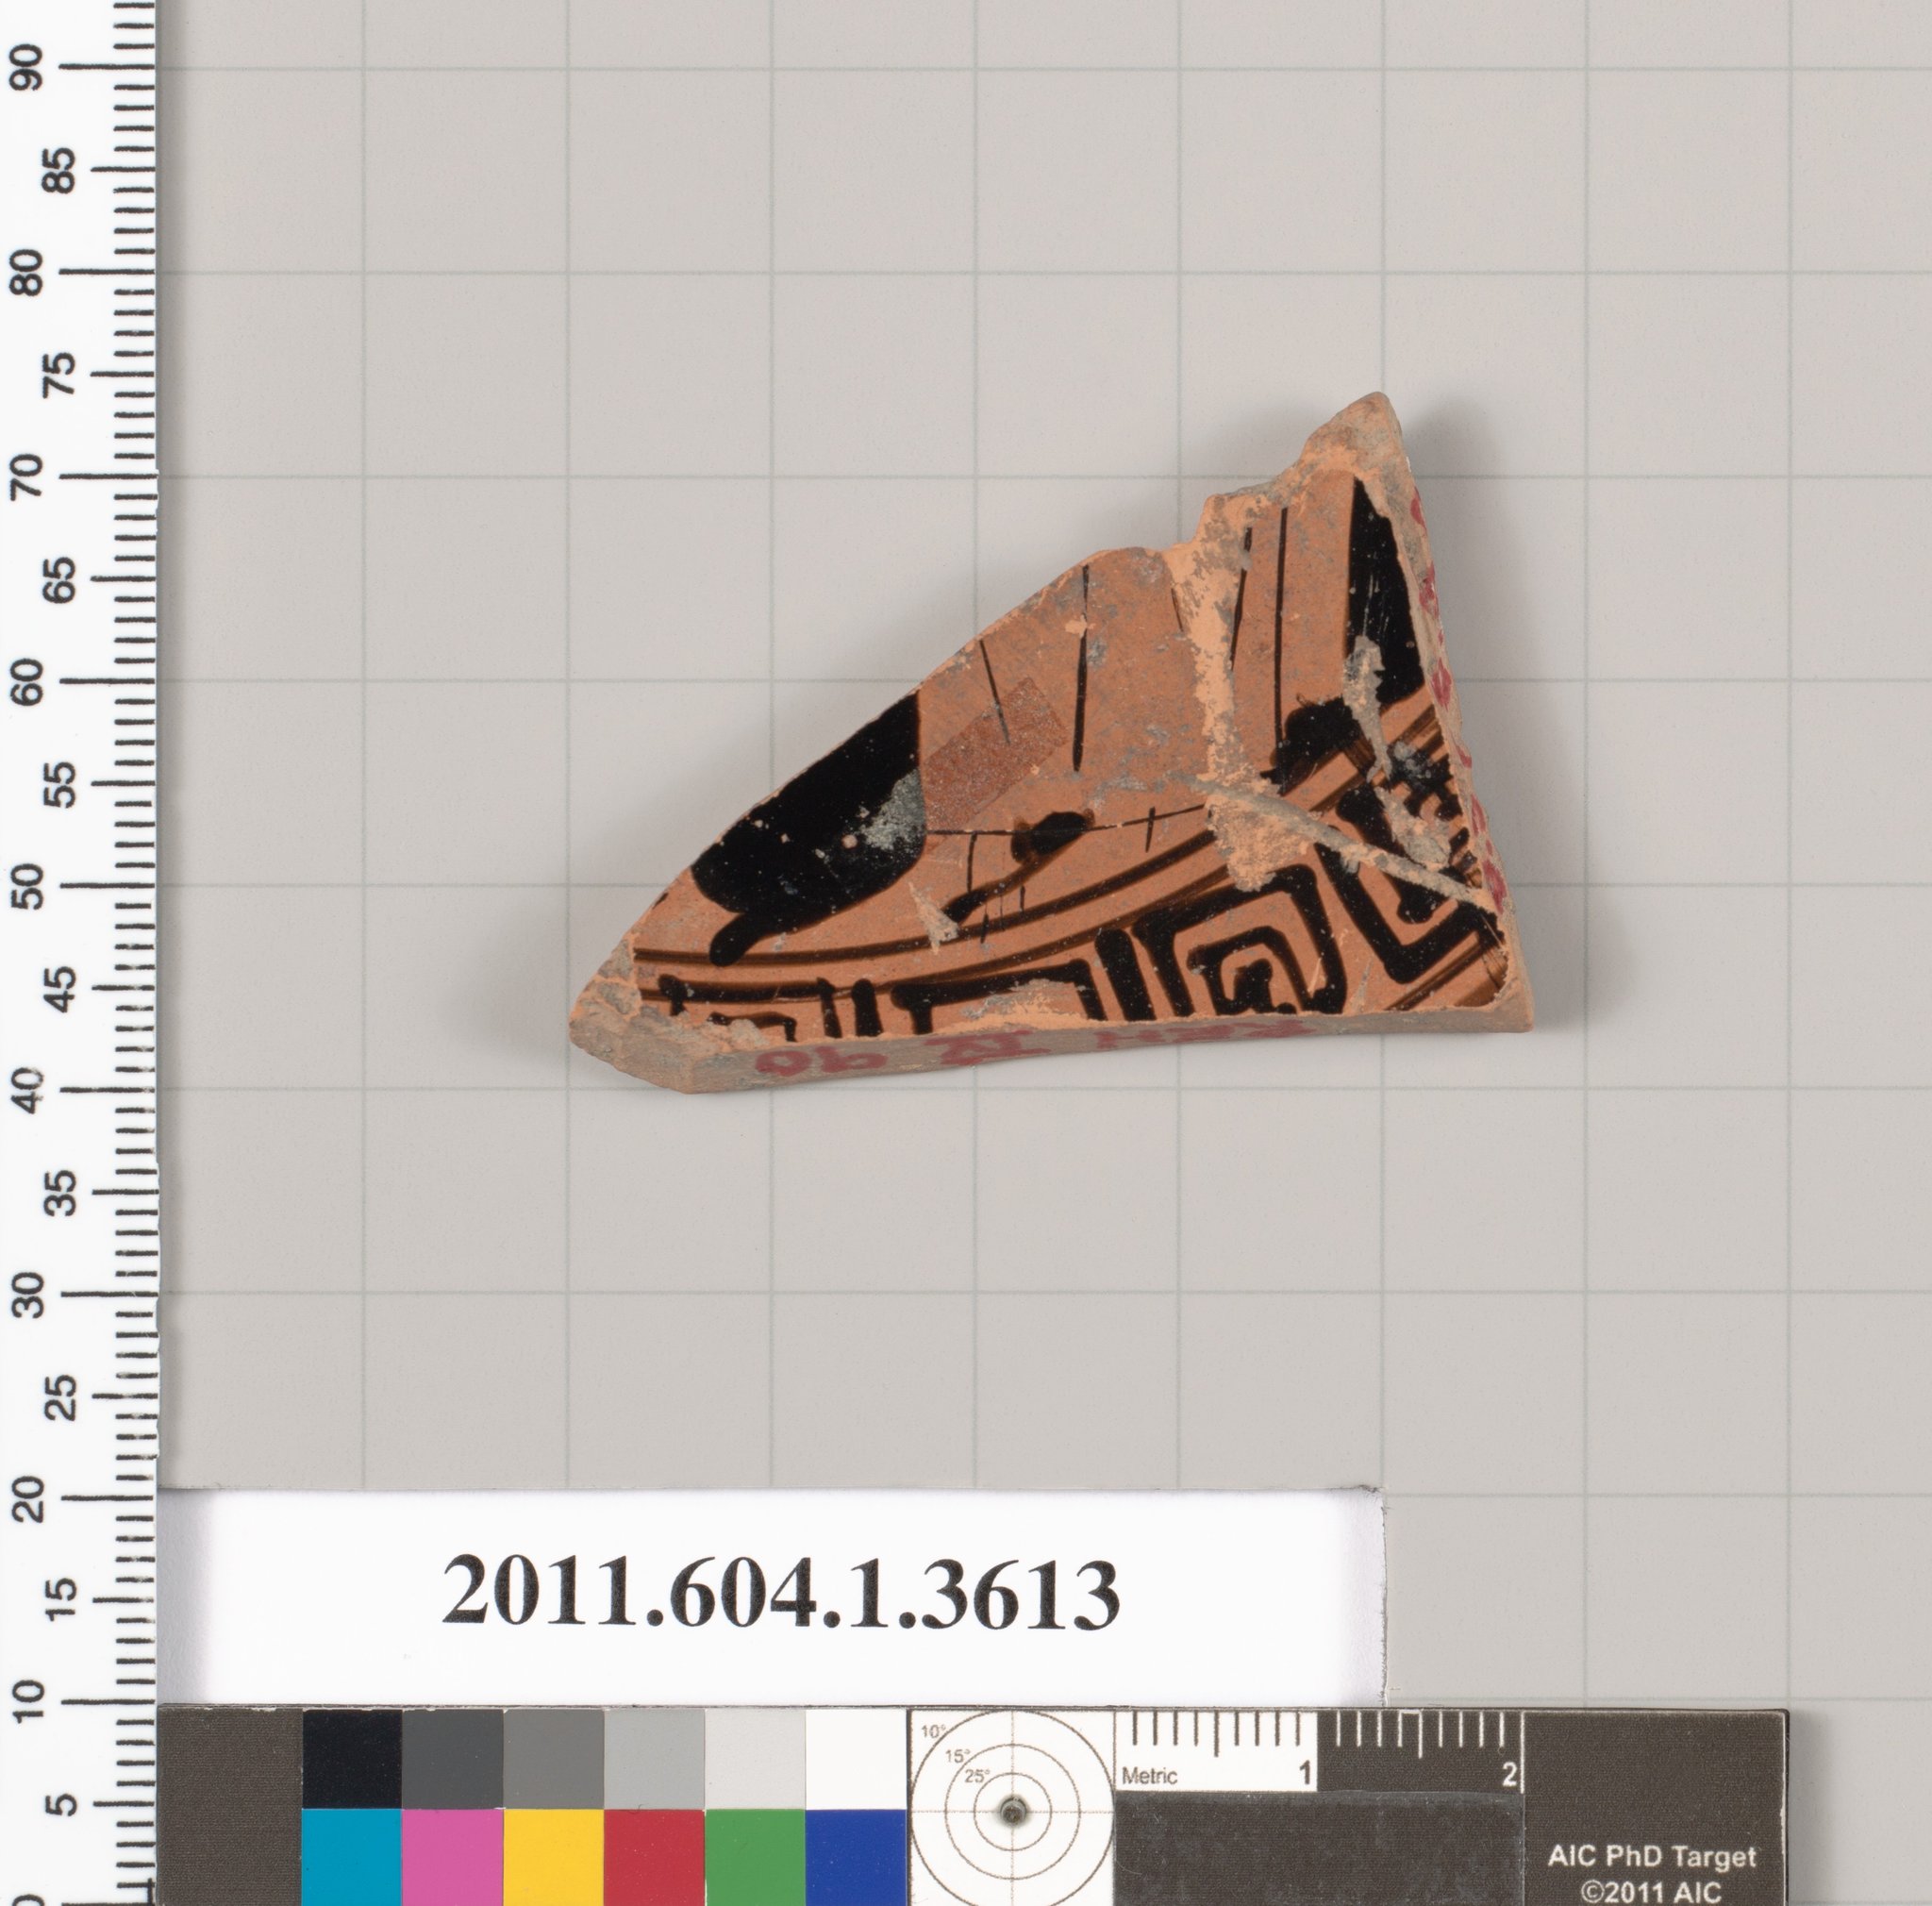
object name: kylix fragment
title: Terracotta fragment of a kylix (drinking cup)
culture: greek, attic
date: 475-451 BCE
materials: terracotta